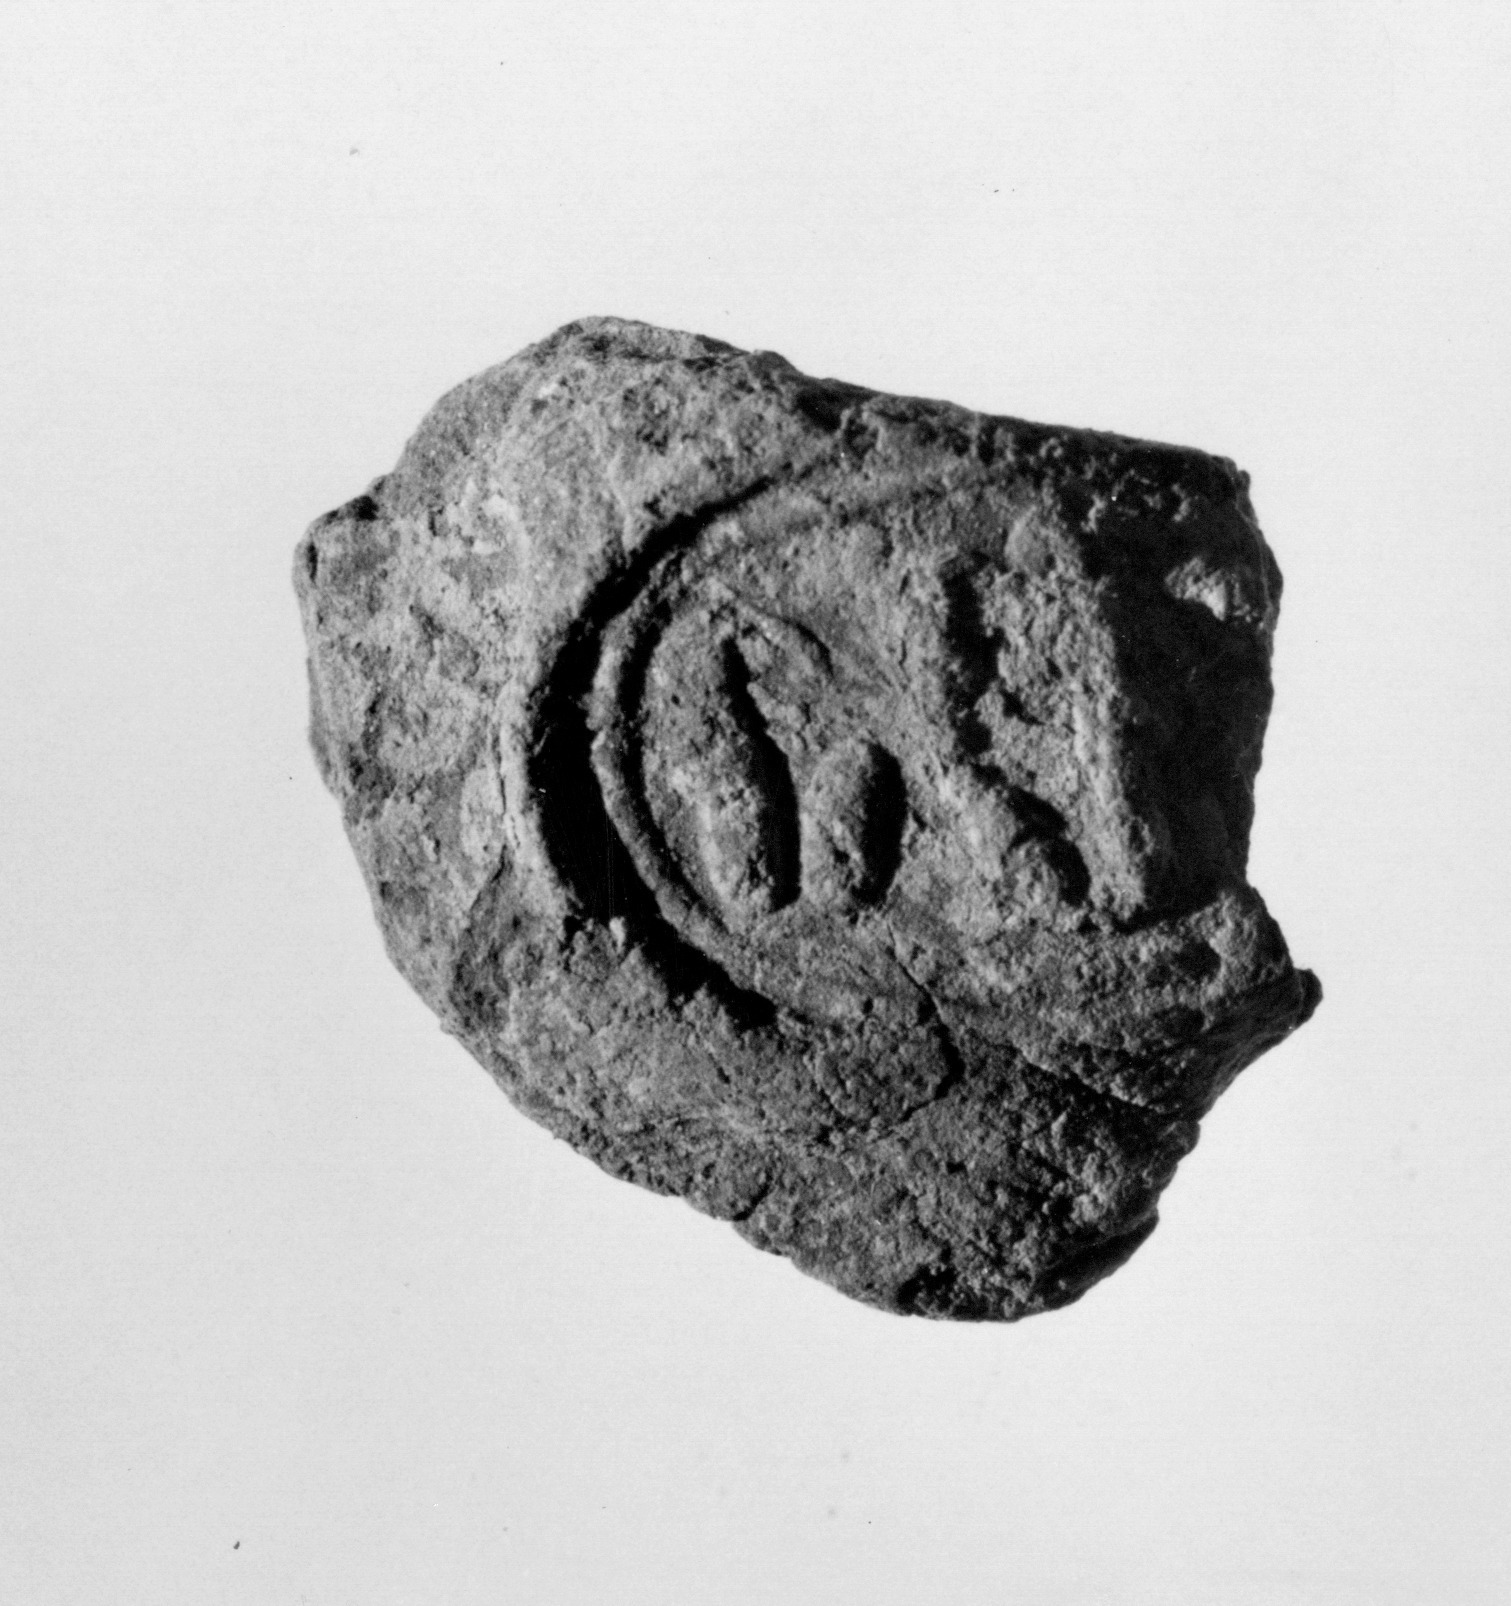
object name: sealing, nebmaatre, amenhotep iii, heb sed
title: Document Sealing With the Throne Name of Amenhotep III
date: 1390-1352 BCE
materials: mud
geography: egypt